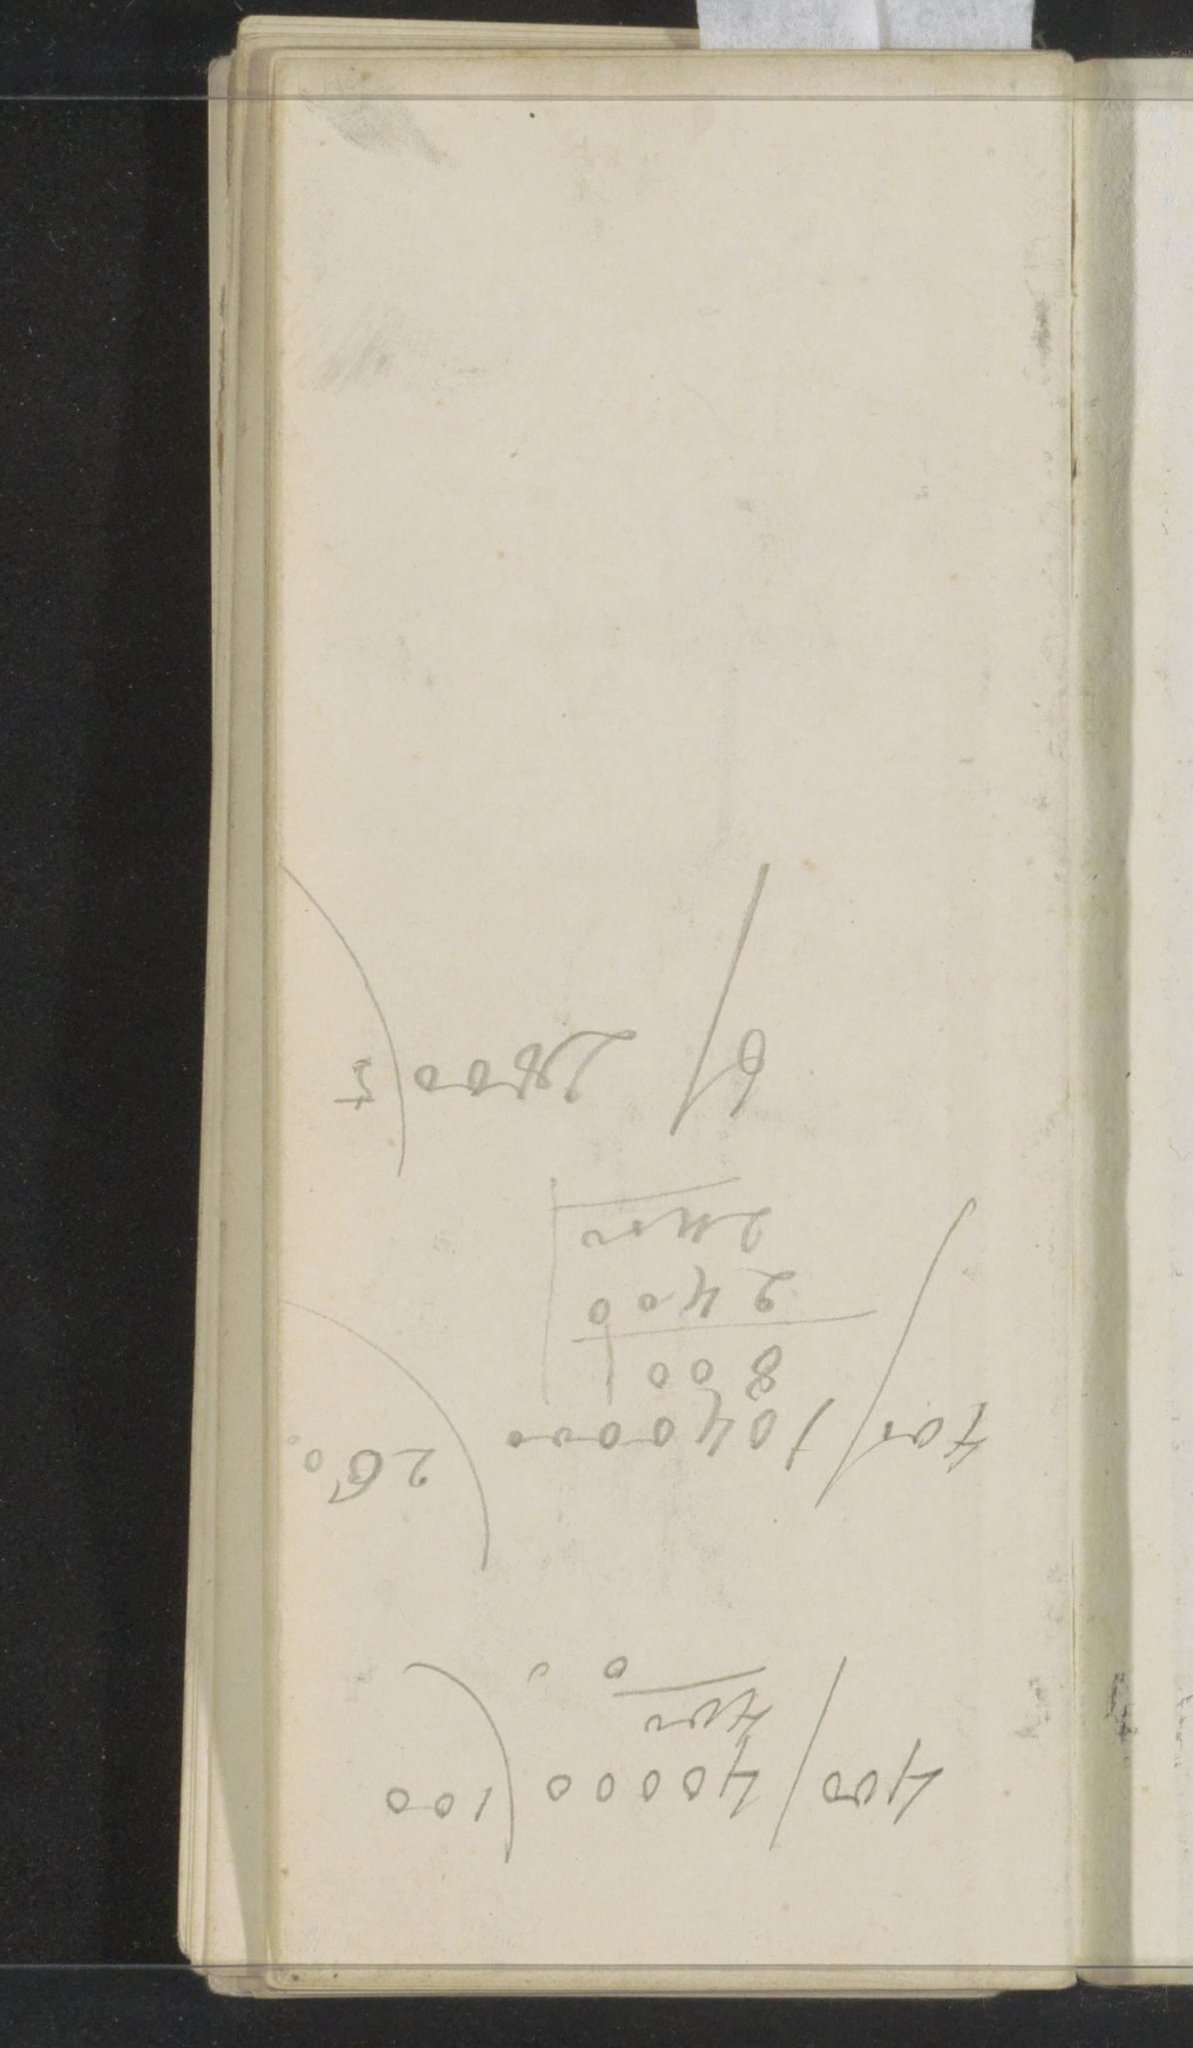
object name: sketchbook leaf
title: Berekeningen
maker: gerrit willem dijsselhof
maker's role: designer, draughtsman, print maker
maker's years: 1866-1924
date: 1901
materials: paper, pencil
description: Blad 42 verso uit een schetsboek met 42 bladzijden.